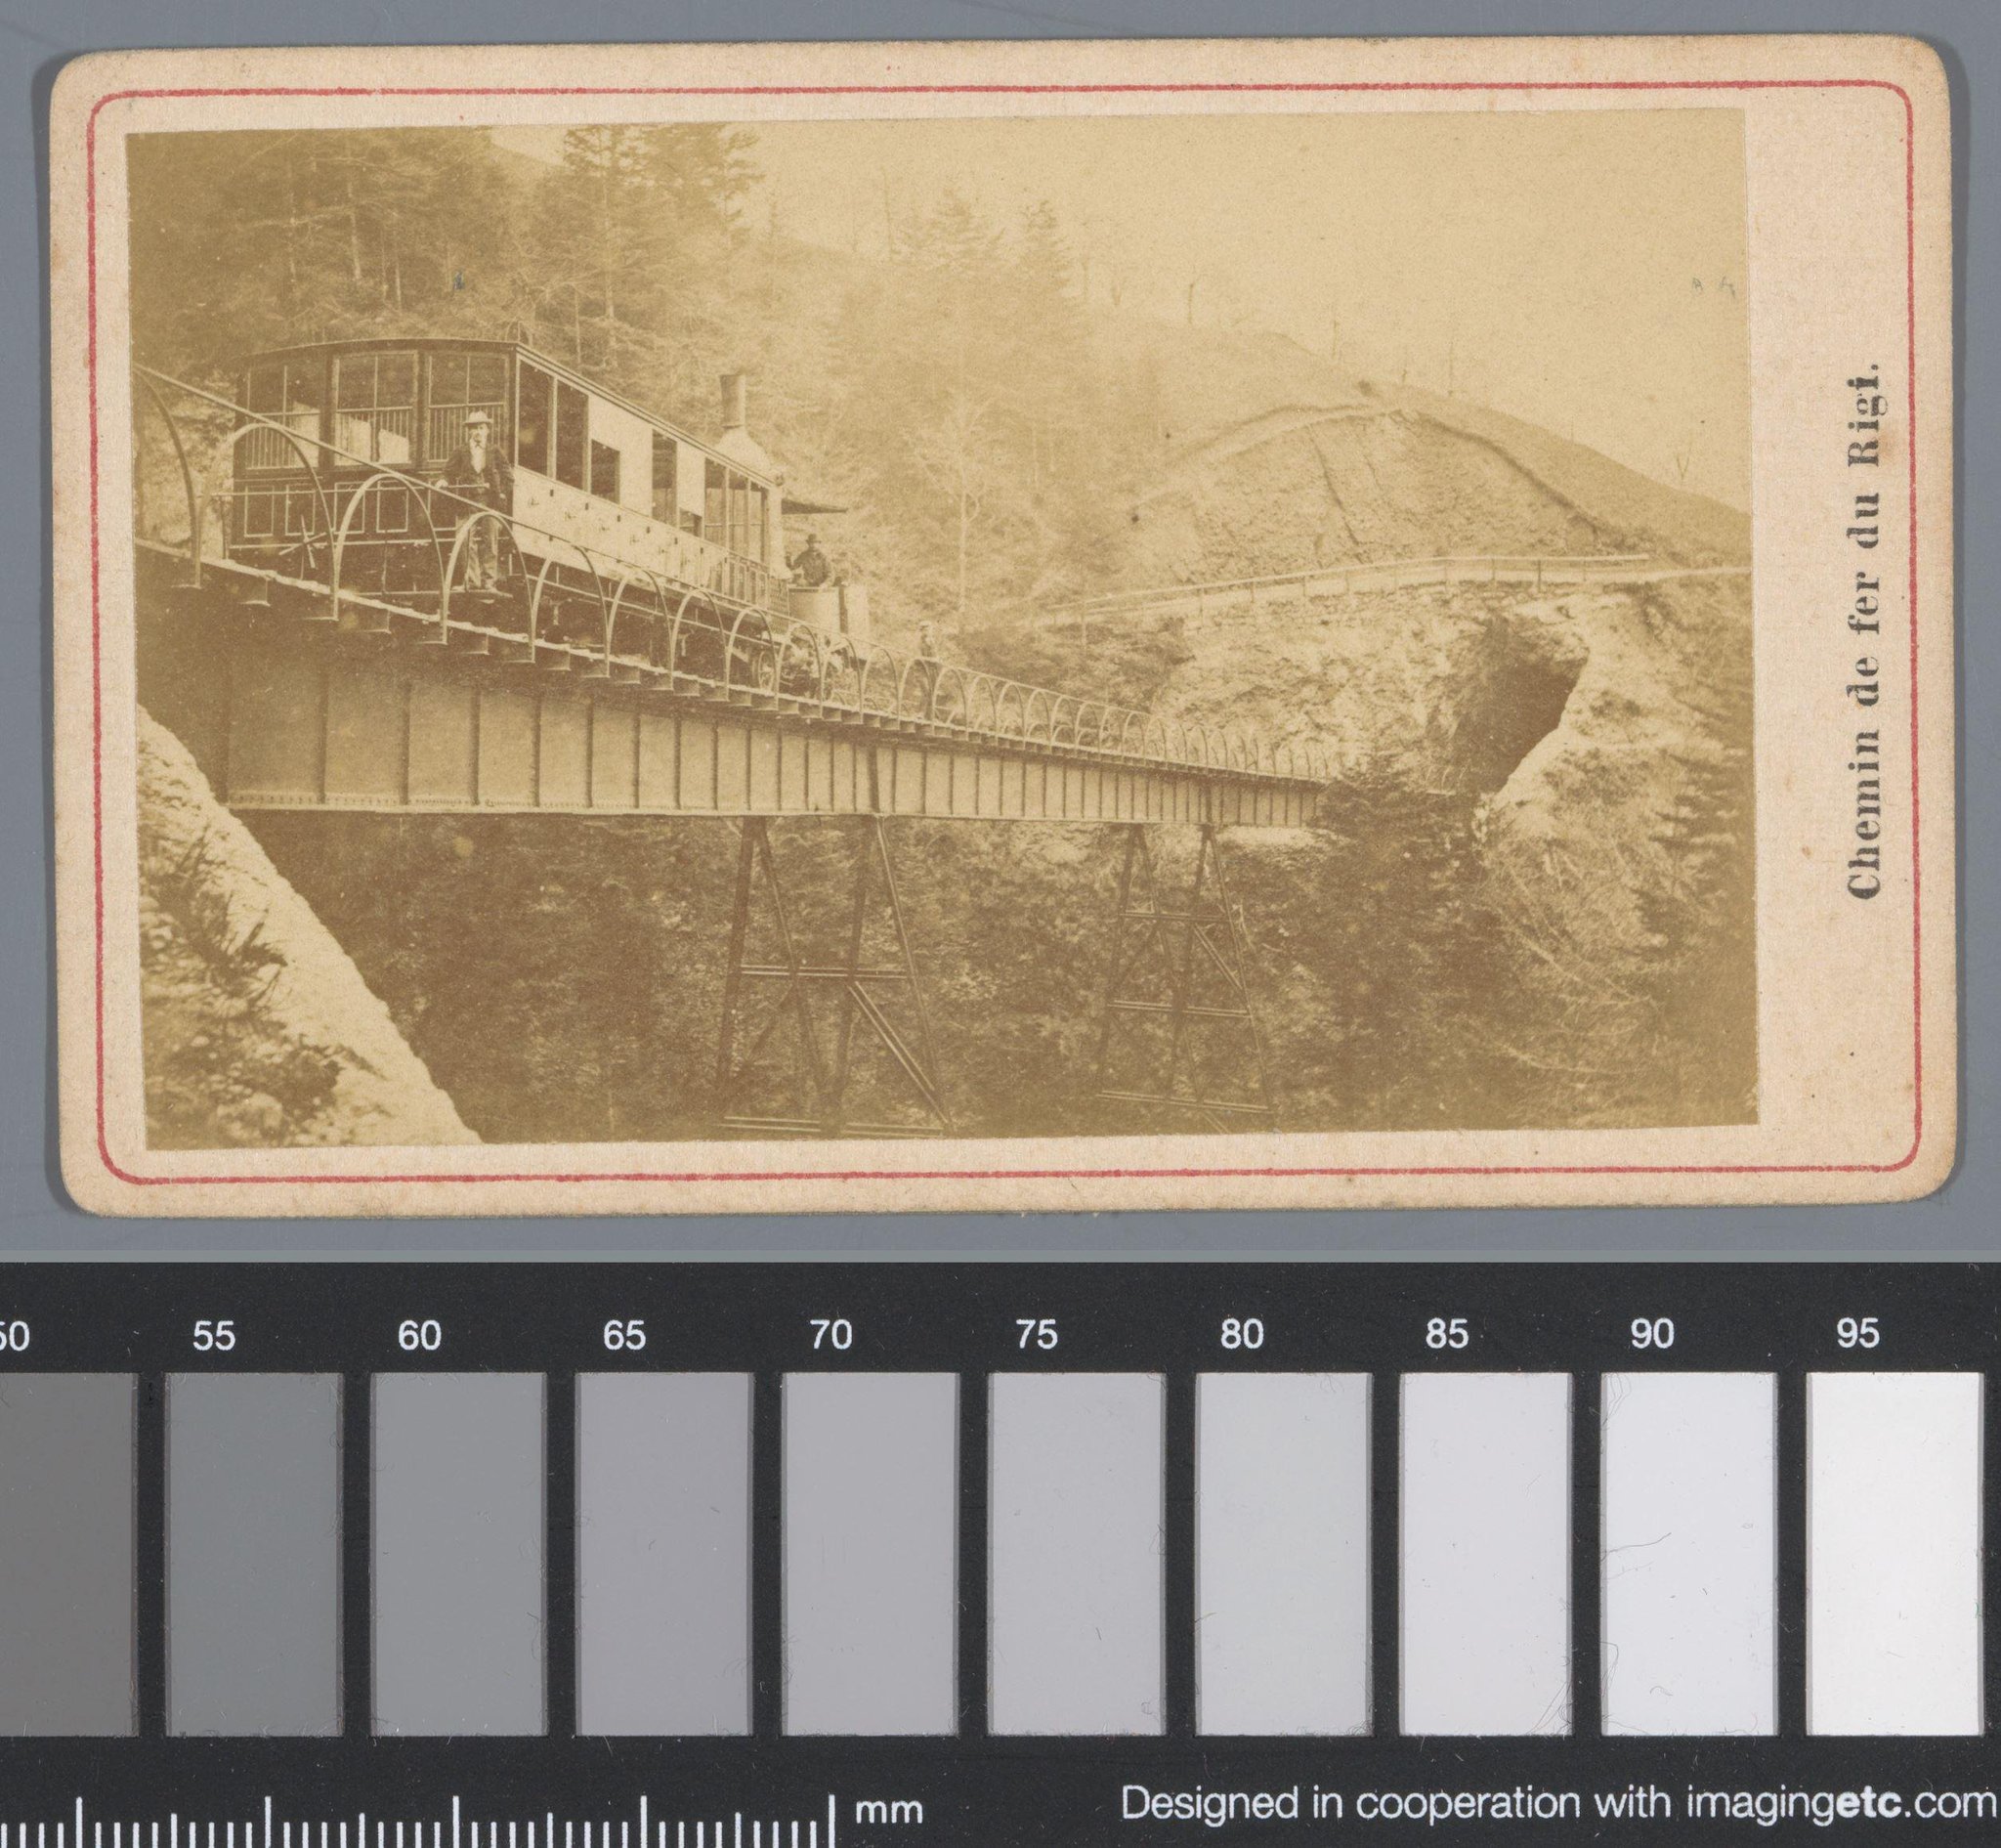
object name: photograph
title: Treinspoor op de Rigi, Zwitserland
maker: Anonymous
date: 1871-1885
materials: cardboard, paper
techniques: albumen print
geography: rigi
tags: railway, train